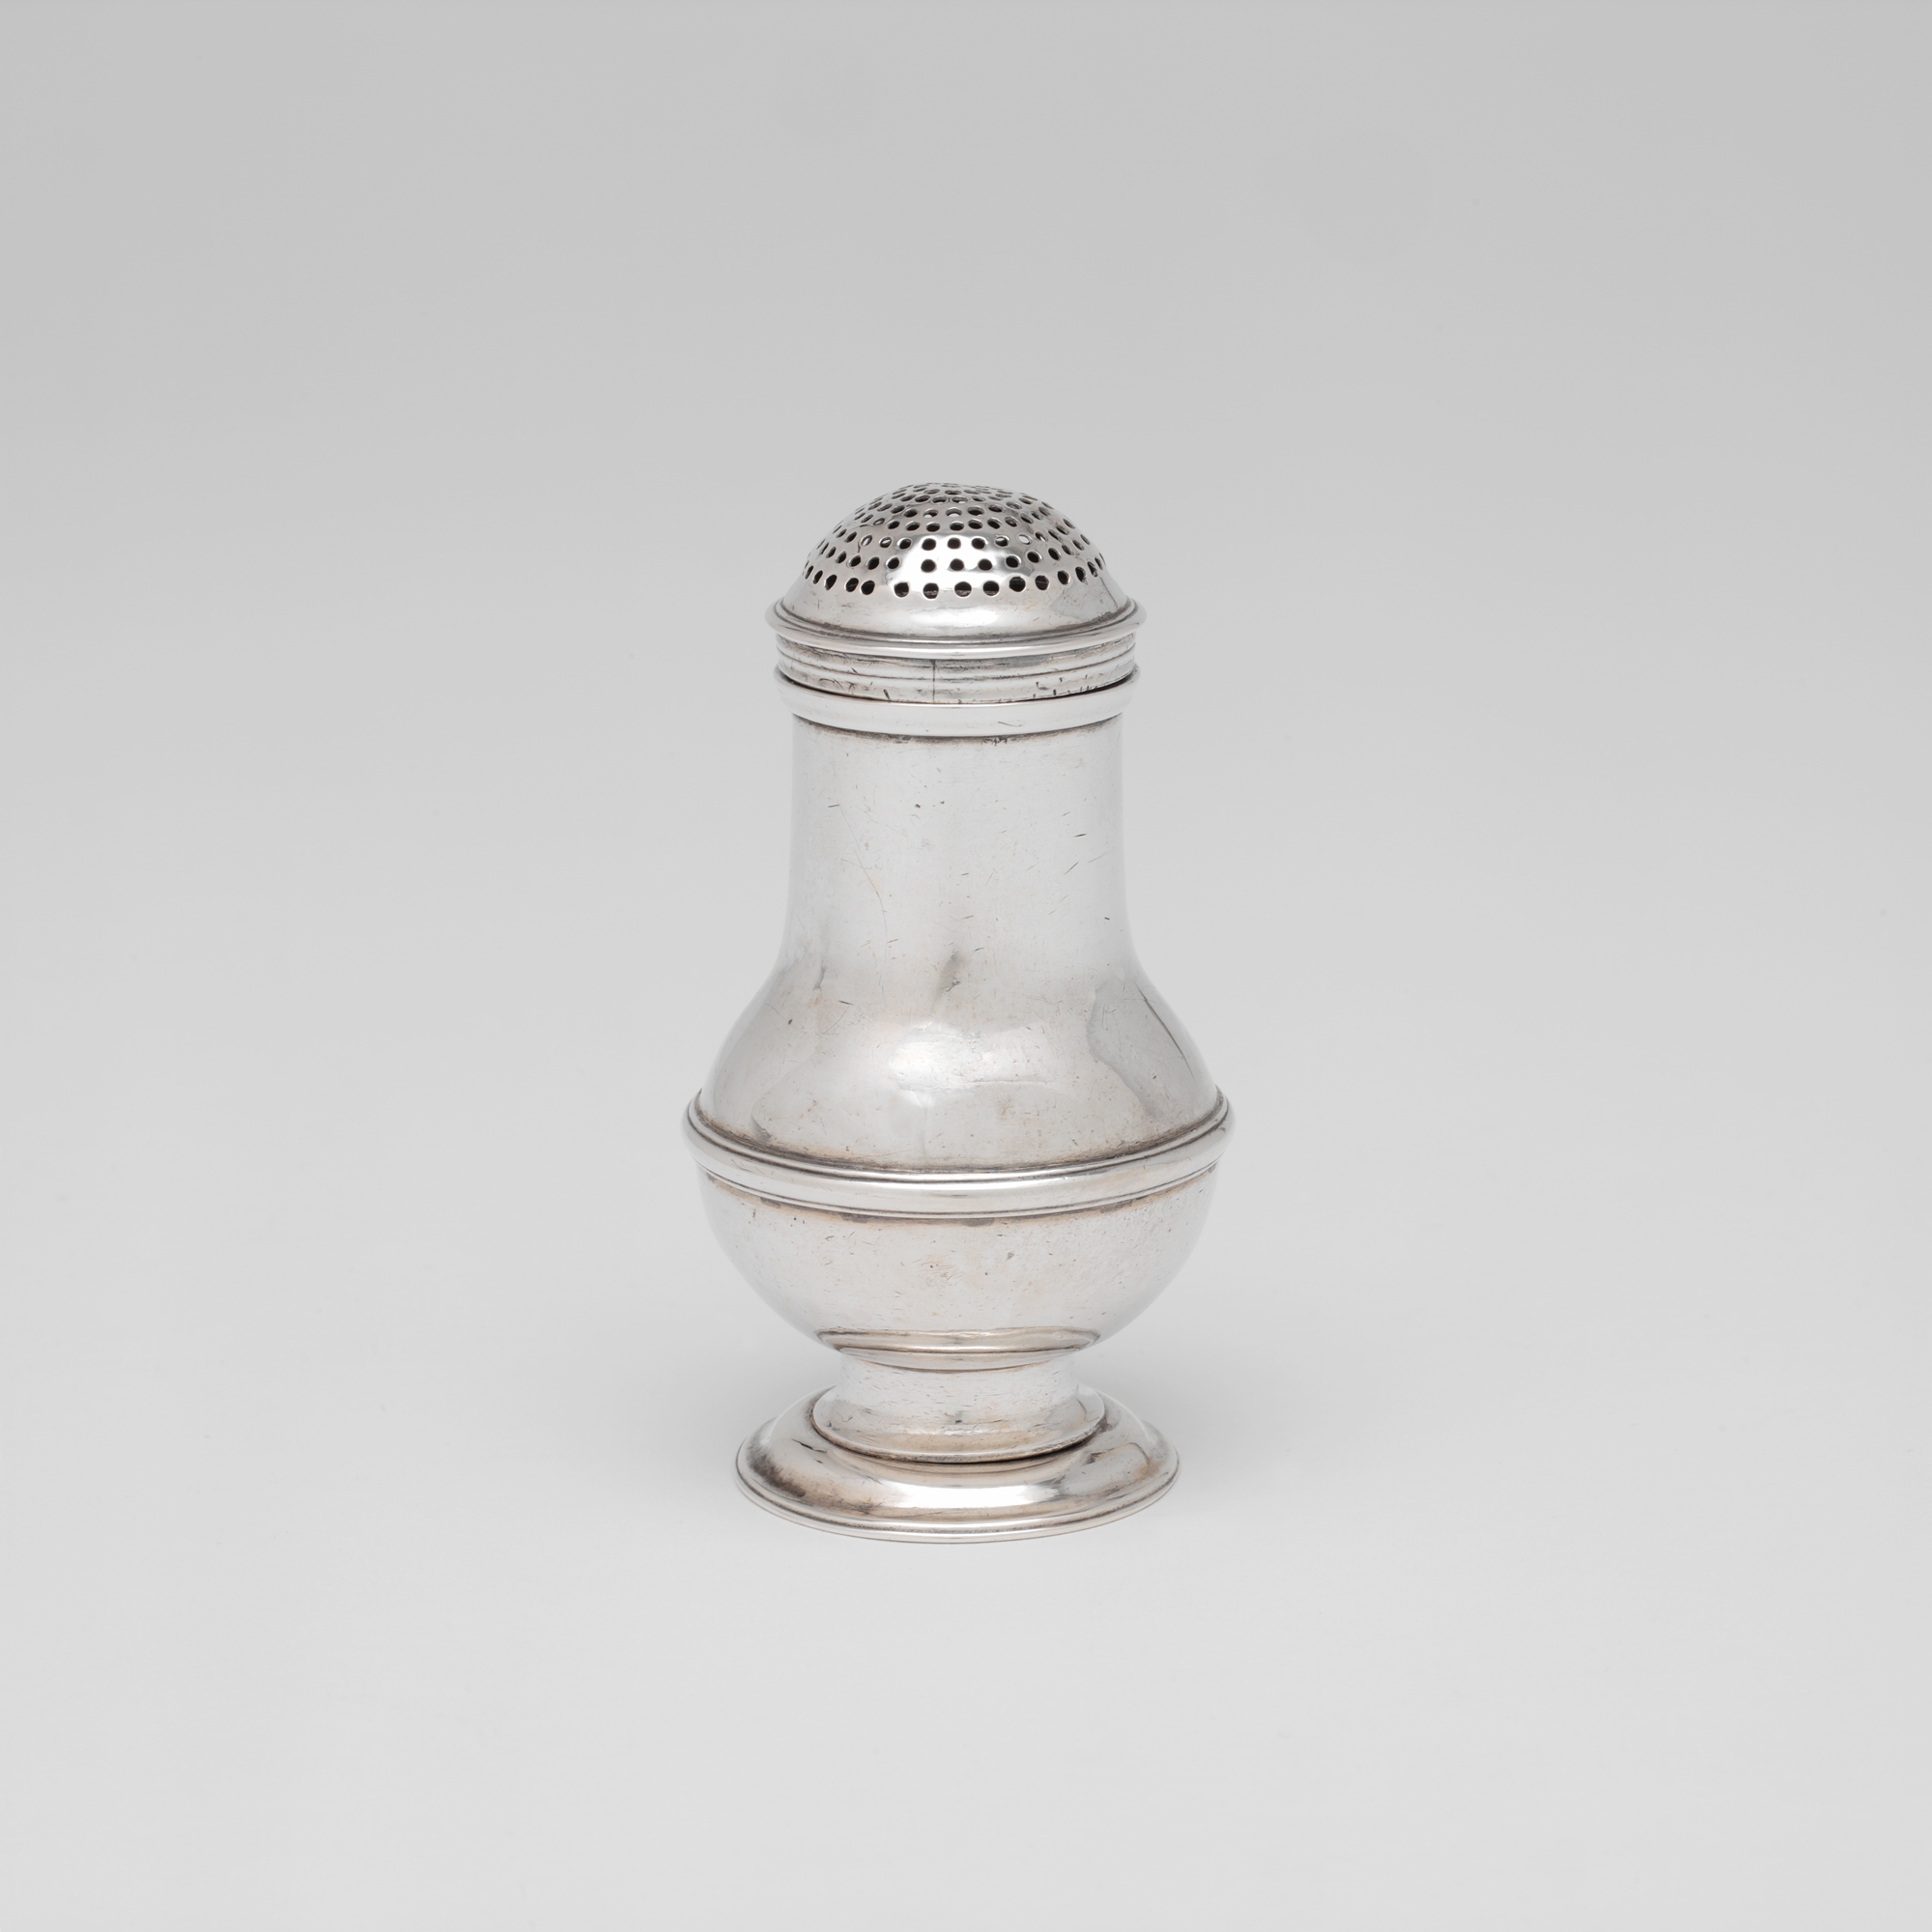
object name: caster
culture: american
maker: samuel johnson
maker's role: maker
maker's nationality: american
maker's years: 1720-1796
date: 1780-1796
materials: silver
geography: united states